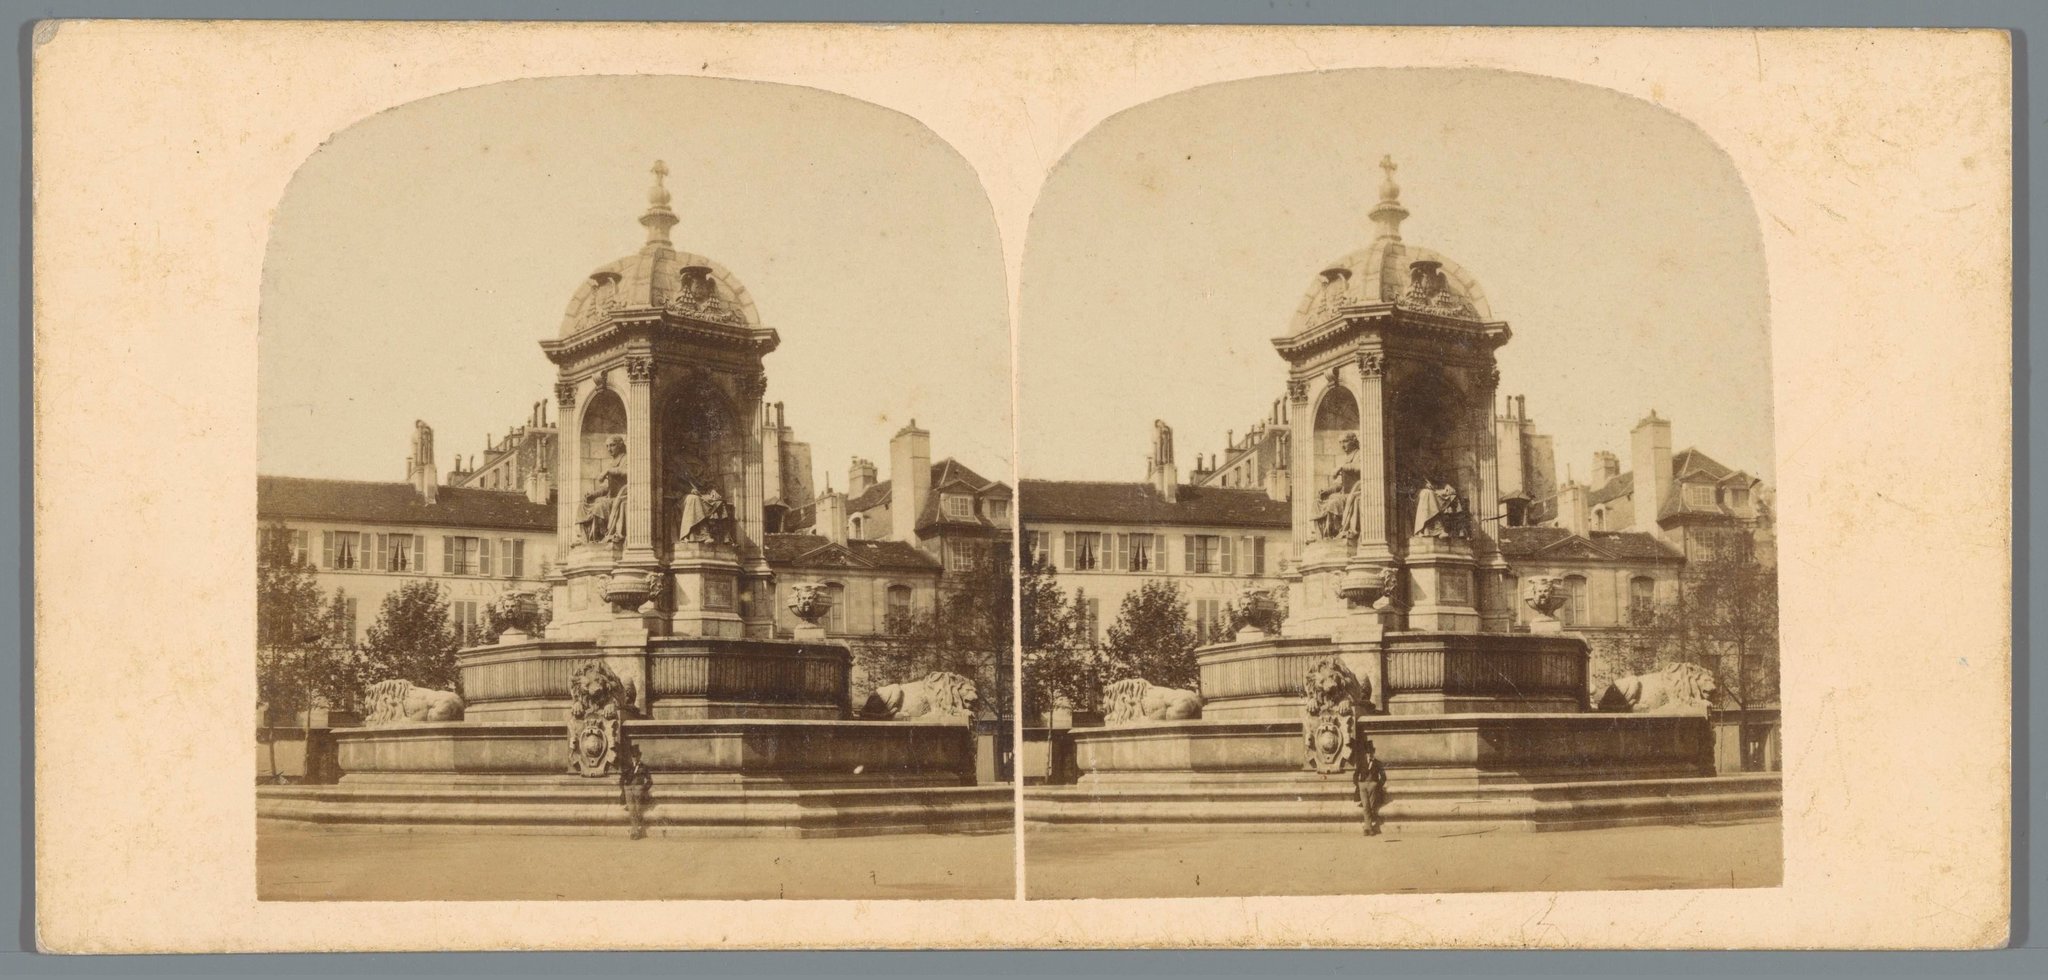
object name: stereograph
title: Gezicht op de Fontaine des Innocents in Parijs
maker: Anonymous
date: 1850-1880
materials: cardboard, photographic support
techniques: albumen print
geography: paris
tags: ornamental fountain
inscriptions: inscription: ‘Parijs Frankrijk Fontaine des Innocents’